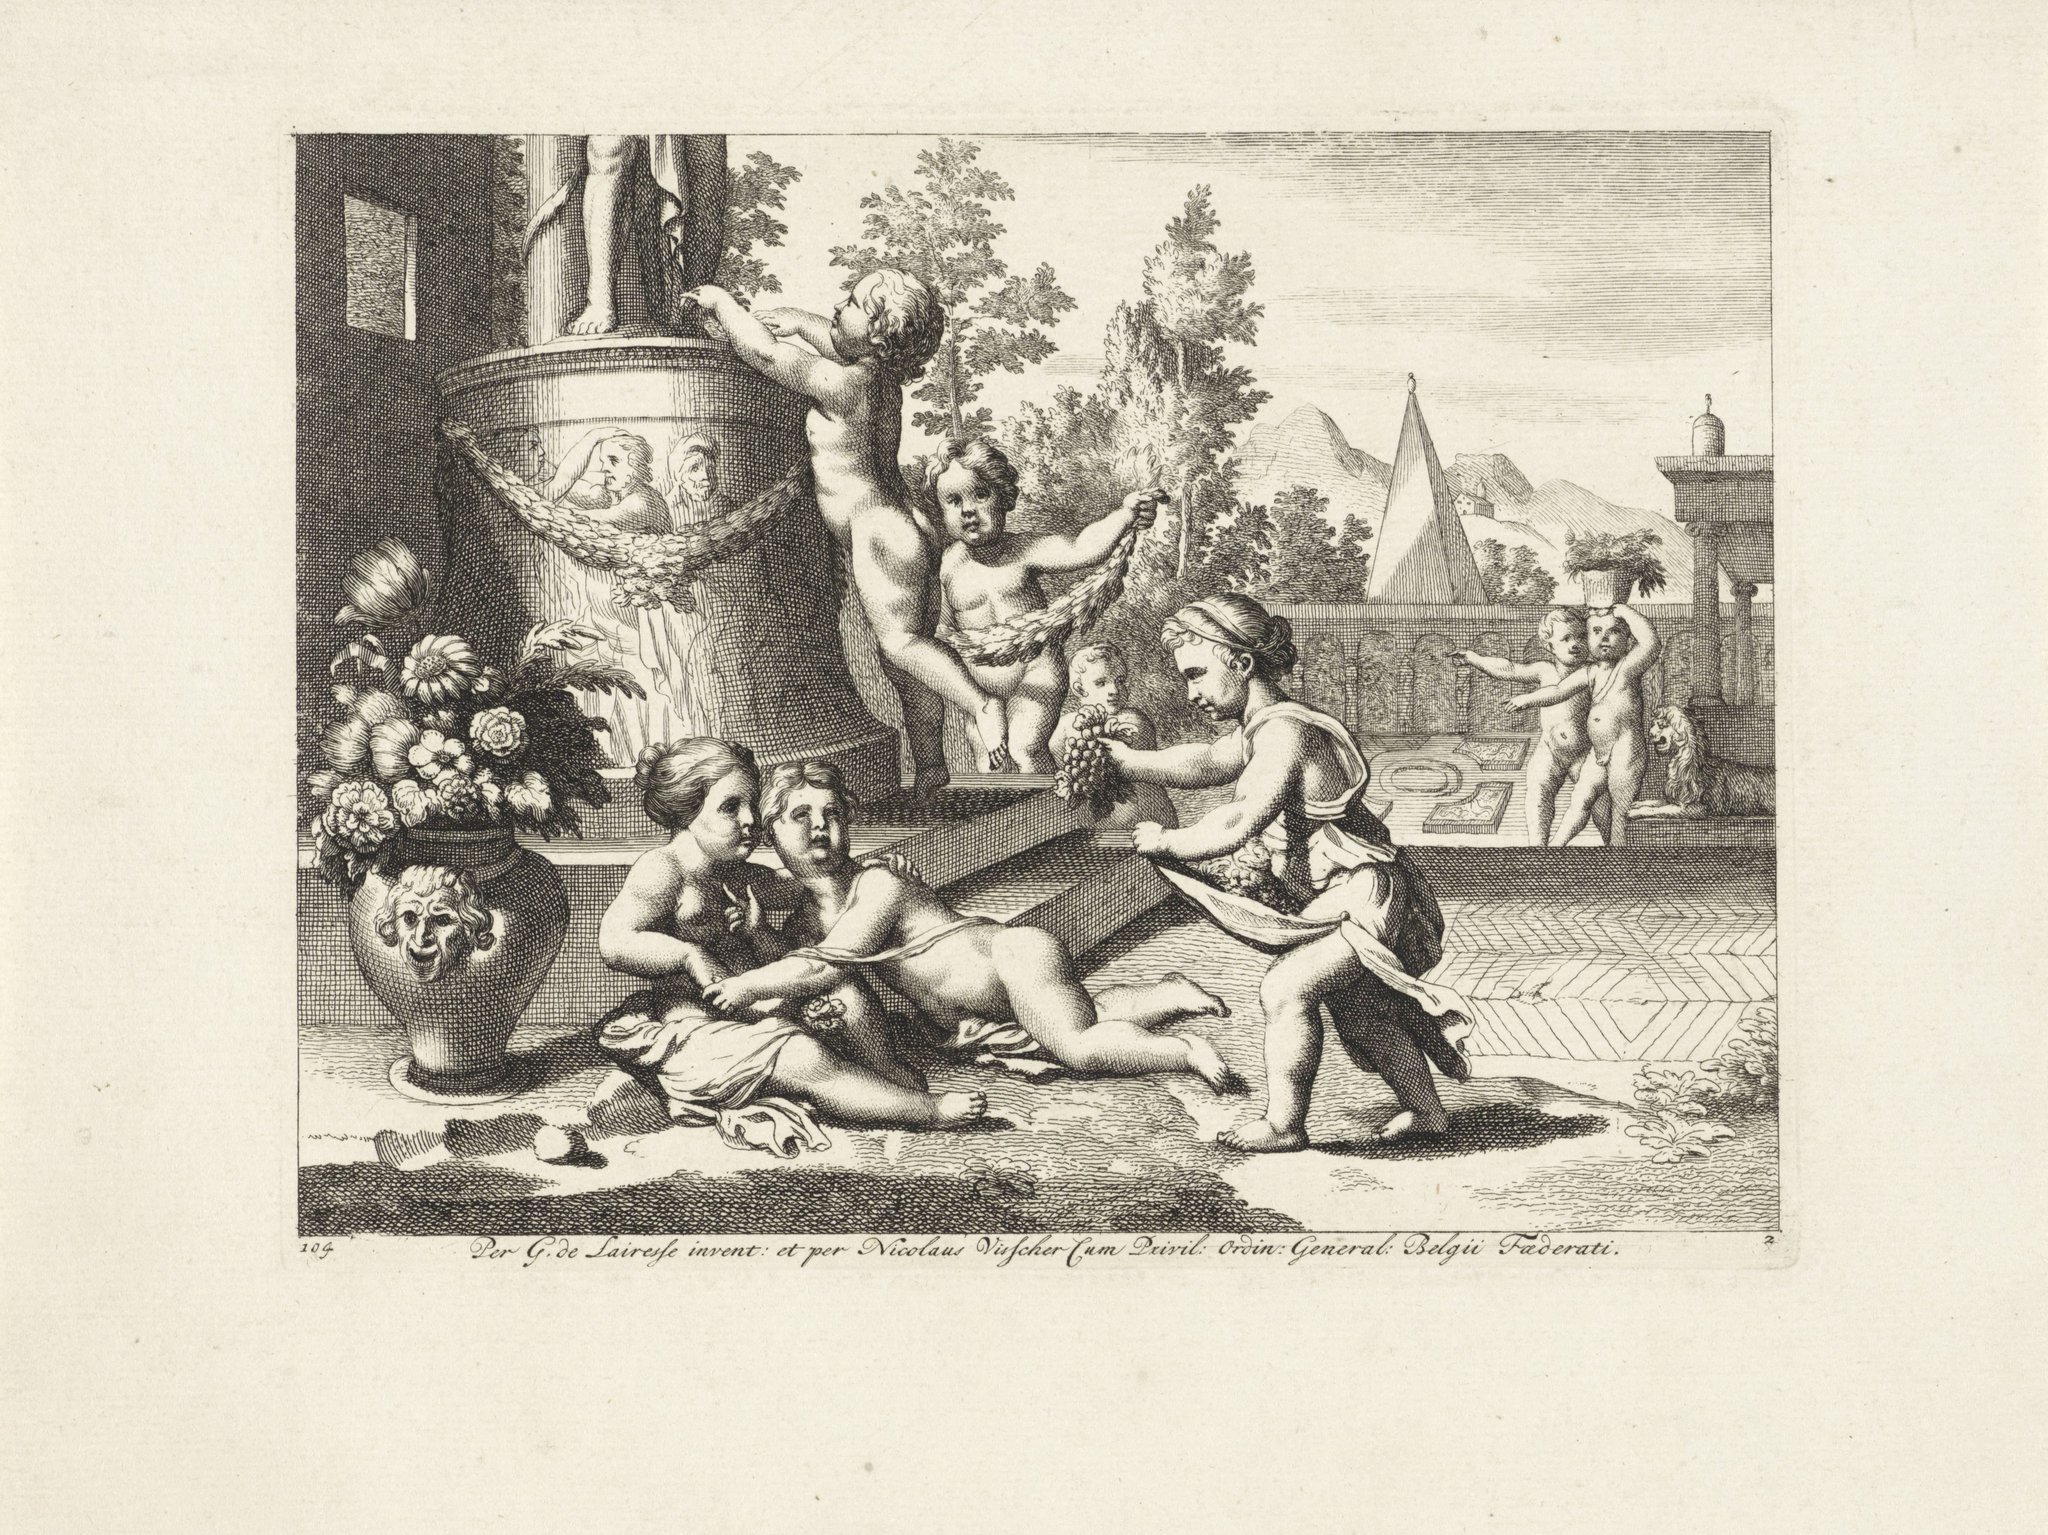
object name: print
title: Spelende putti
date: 1670-1690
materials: paper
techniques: engraving, etching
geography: amsterdam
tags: sculpture, cupids: 'amores', 'amoretti', 'putti', other decorative structures (~ triumphal entry, etc.), grape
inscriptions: collector's mark: Lugt 2228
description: Links versieren enkele putti een sculptuur op een sokkel met guirlandes. Vooraan biedt een putto twee putti op de grond druiventrossen aan. Rechtsachter nog twee putti. Eén van hen heeft een mand op zijn hoofd. Linksonder: 104.